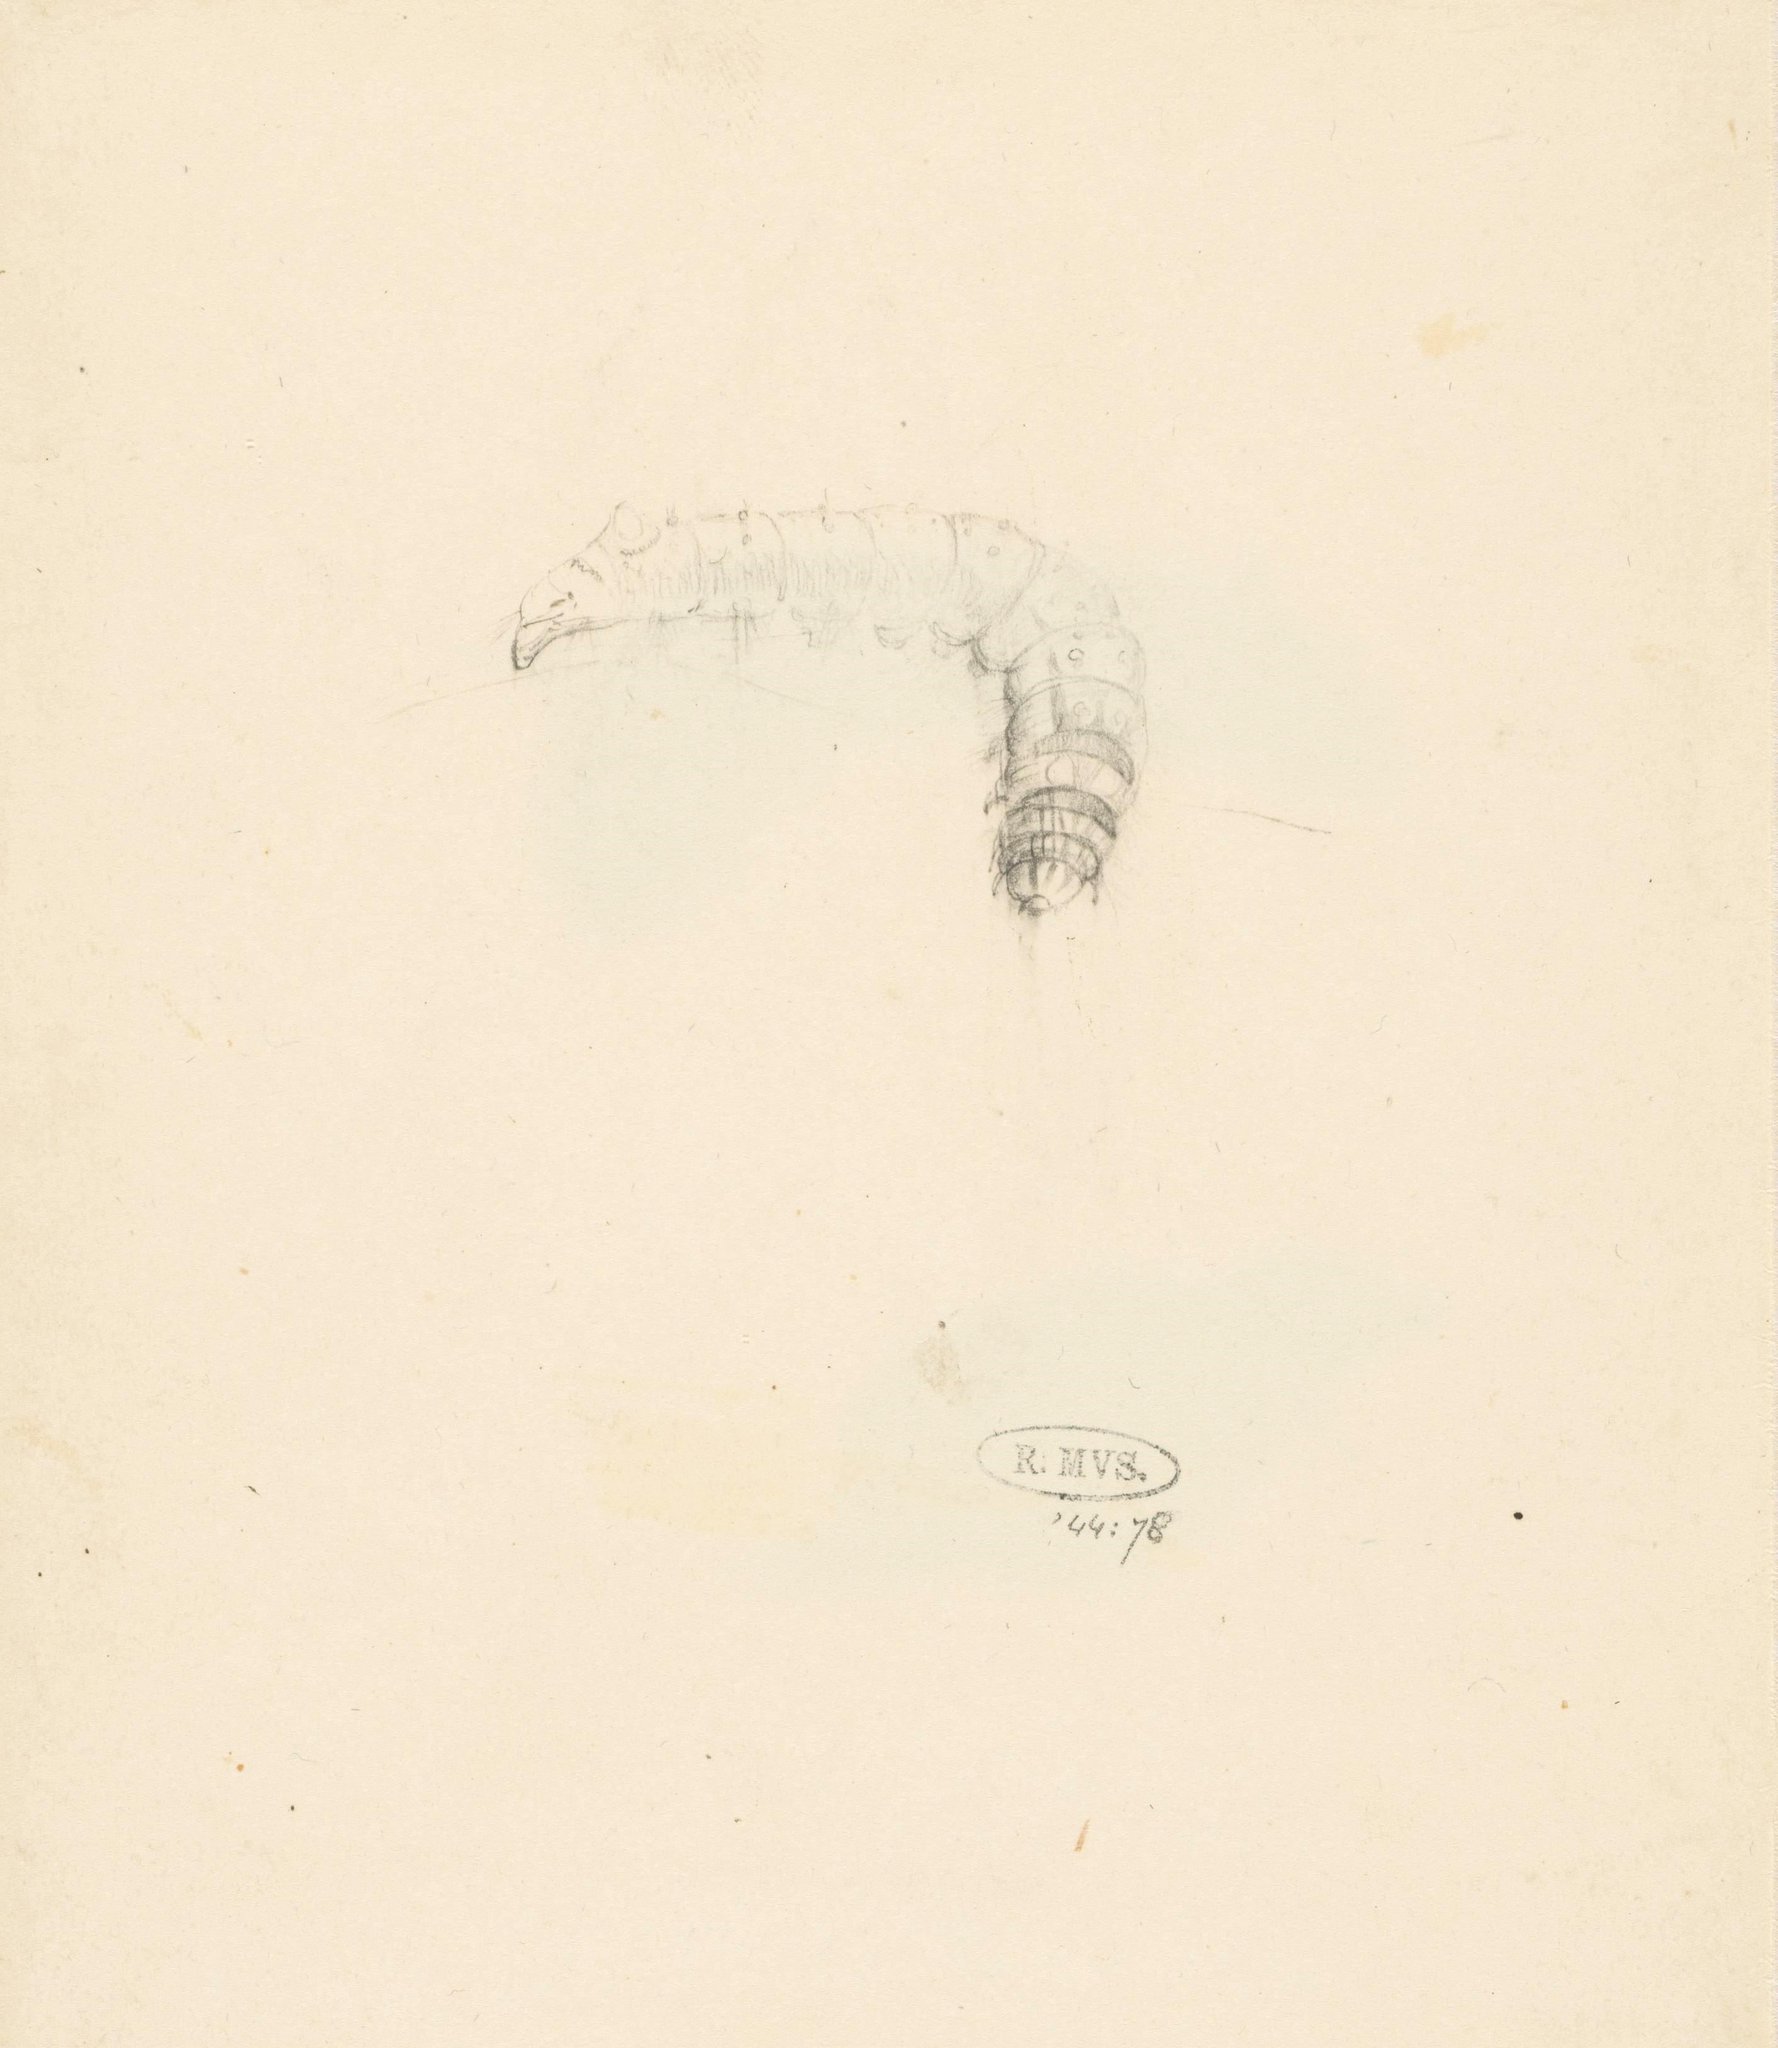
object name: drawing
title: Studieblad met rups, Lasiocampa Quireifolia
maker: albertus steenbergen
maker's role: draughtsman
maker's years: 1814-1900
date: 1824-1900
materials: paper, pencil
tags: insects: caterpillar